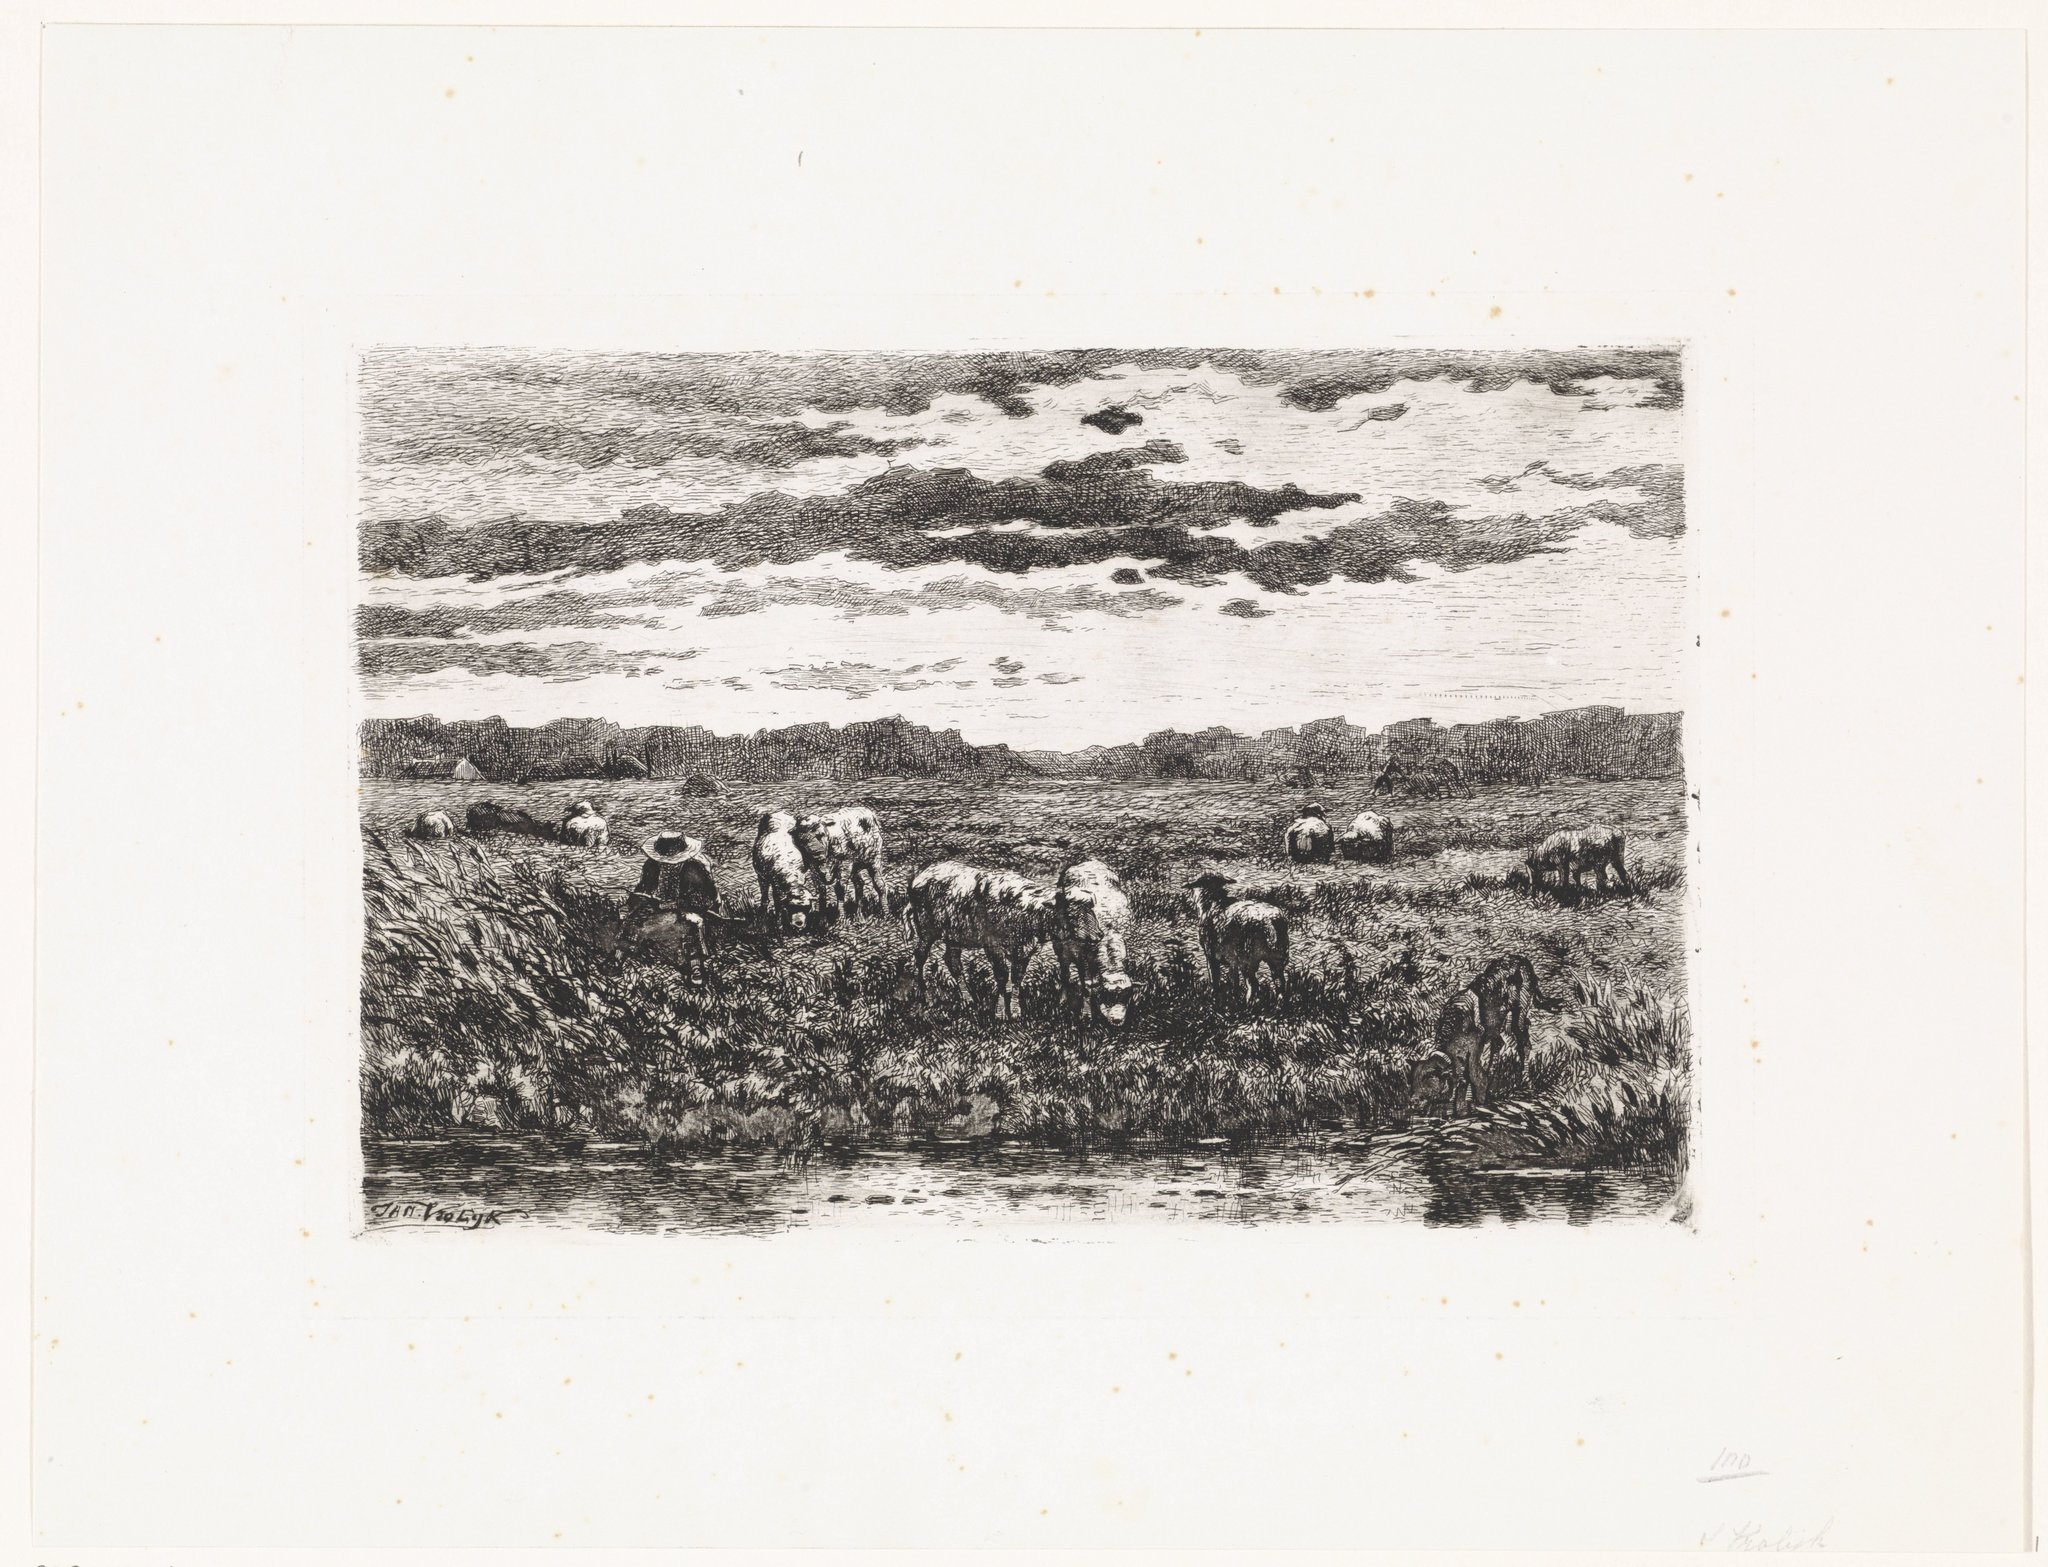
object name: print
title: Landschap met schapen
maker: jan vrolijk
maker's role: draughtsman, painter, print maker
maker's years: 1846-1894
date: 1860-1894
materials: paper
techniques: etching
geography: the hague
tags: meadow, pasture, sheep, small canal, ditch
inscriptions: collector's mark: Lugt 2228, collector's mark: Lugt 2760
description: Schapen grazen in een weiland, langs een sloot. Een man met een breedgerande hoed op het hoofd zit bij hen in het gras.